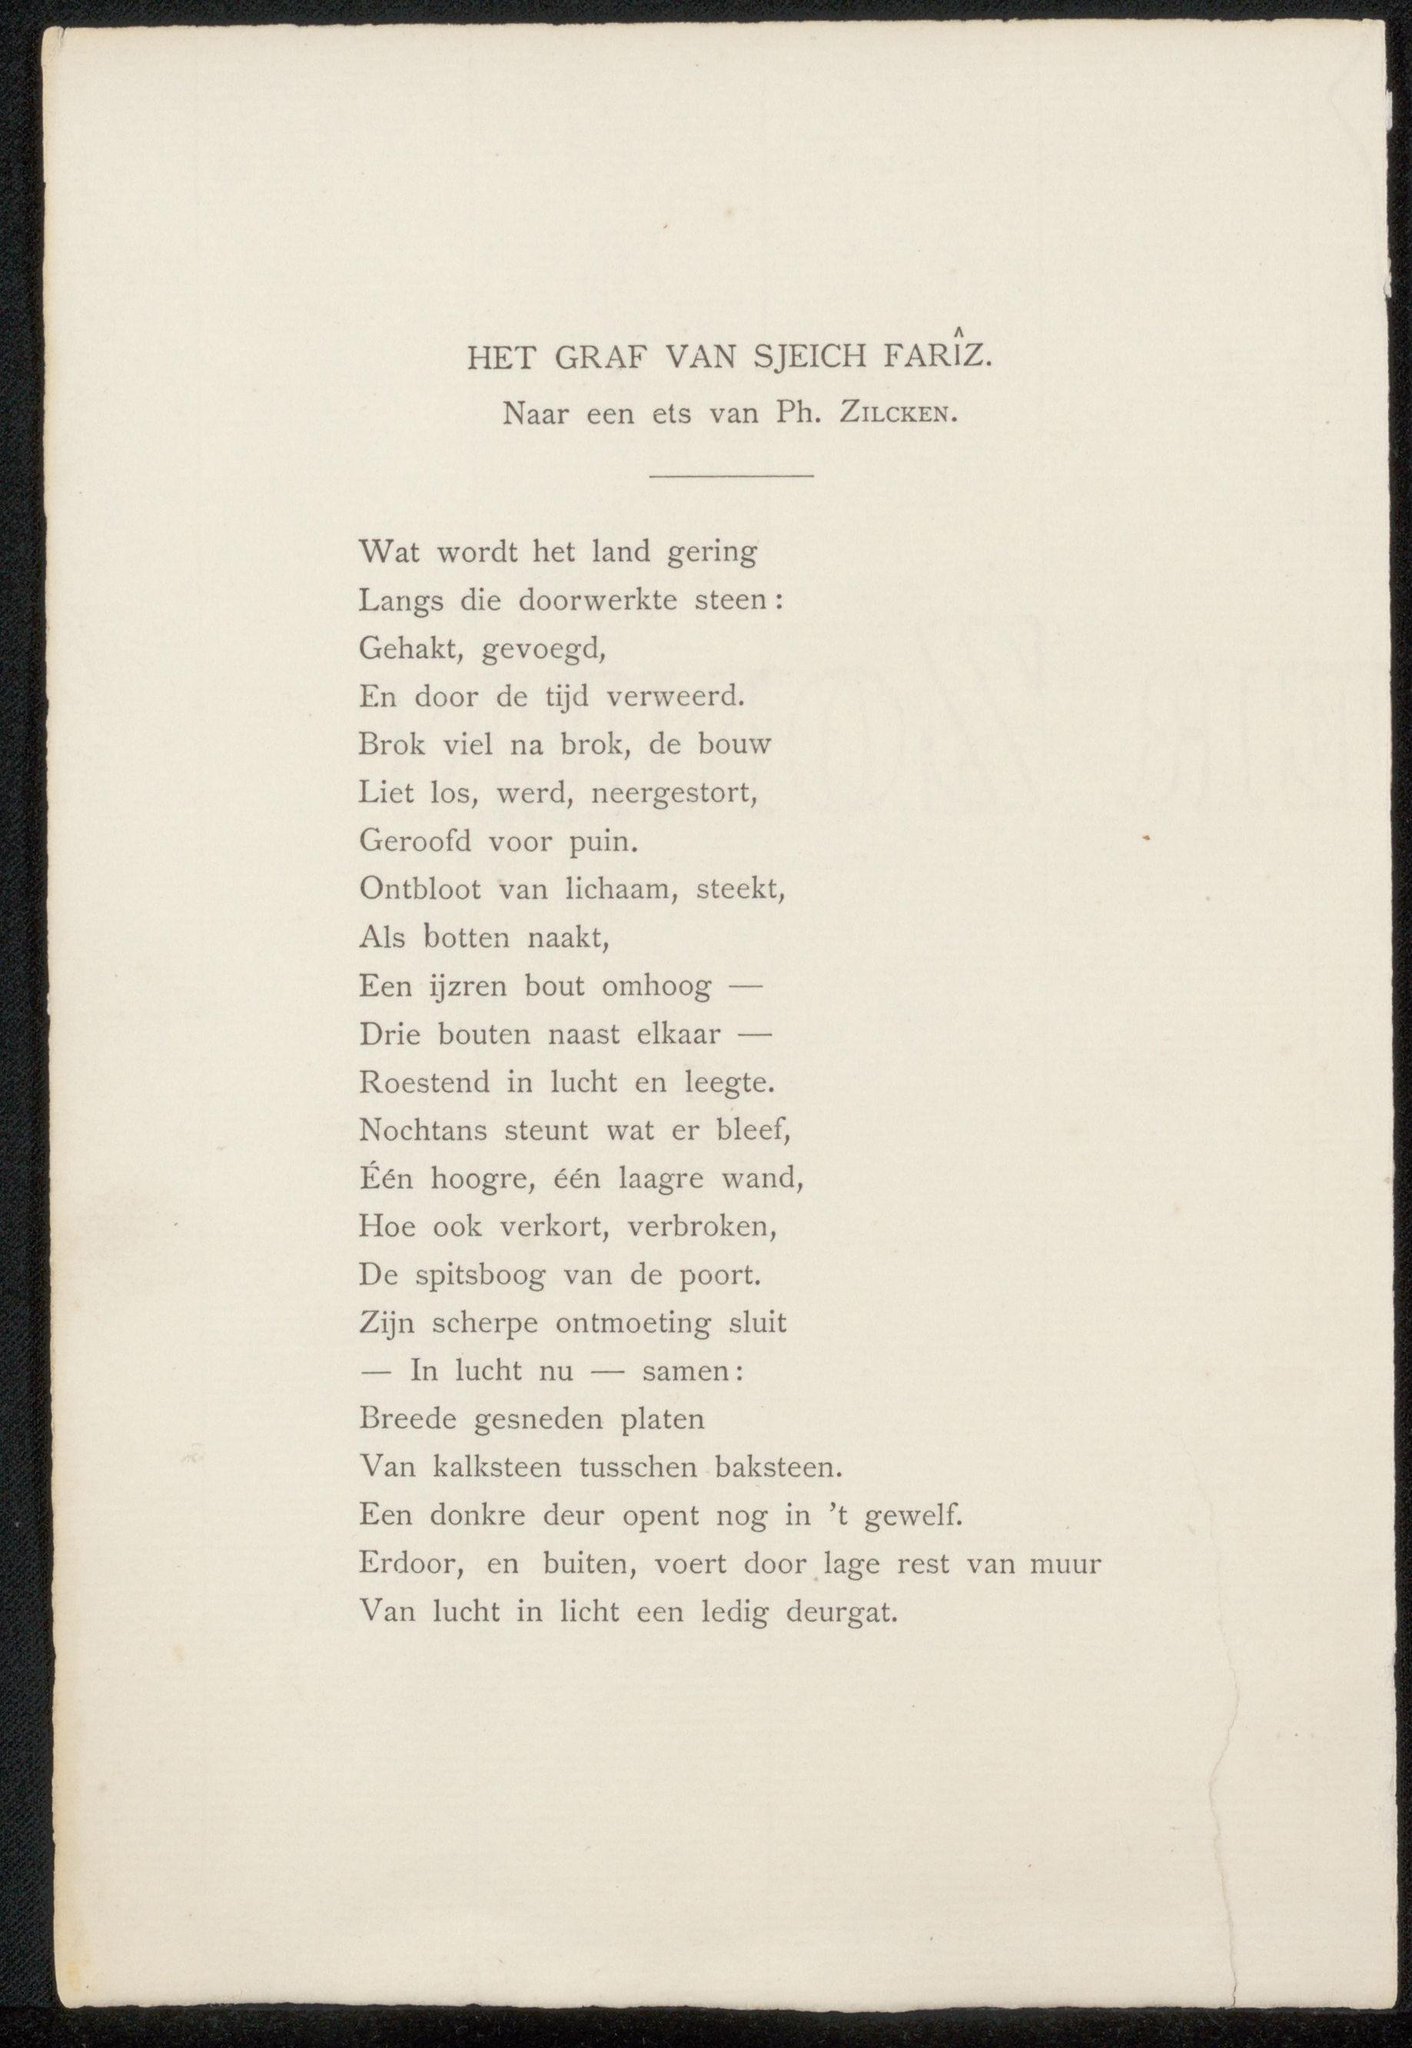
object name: poem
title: Gedicht uit archief Philip Zilcken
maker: albert verwey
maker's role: criticus, dichter, essayist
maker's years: 1865-1937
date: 1913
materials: paper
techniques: printing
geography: noordwijk aan zee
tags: the hague, painter, draughtsman, philip zilcken, literature ~ arts, the graphic arts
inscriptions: watermark, collector's mark: ‘RPK’